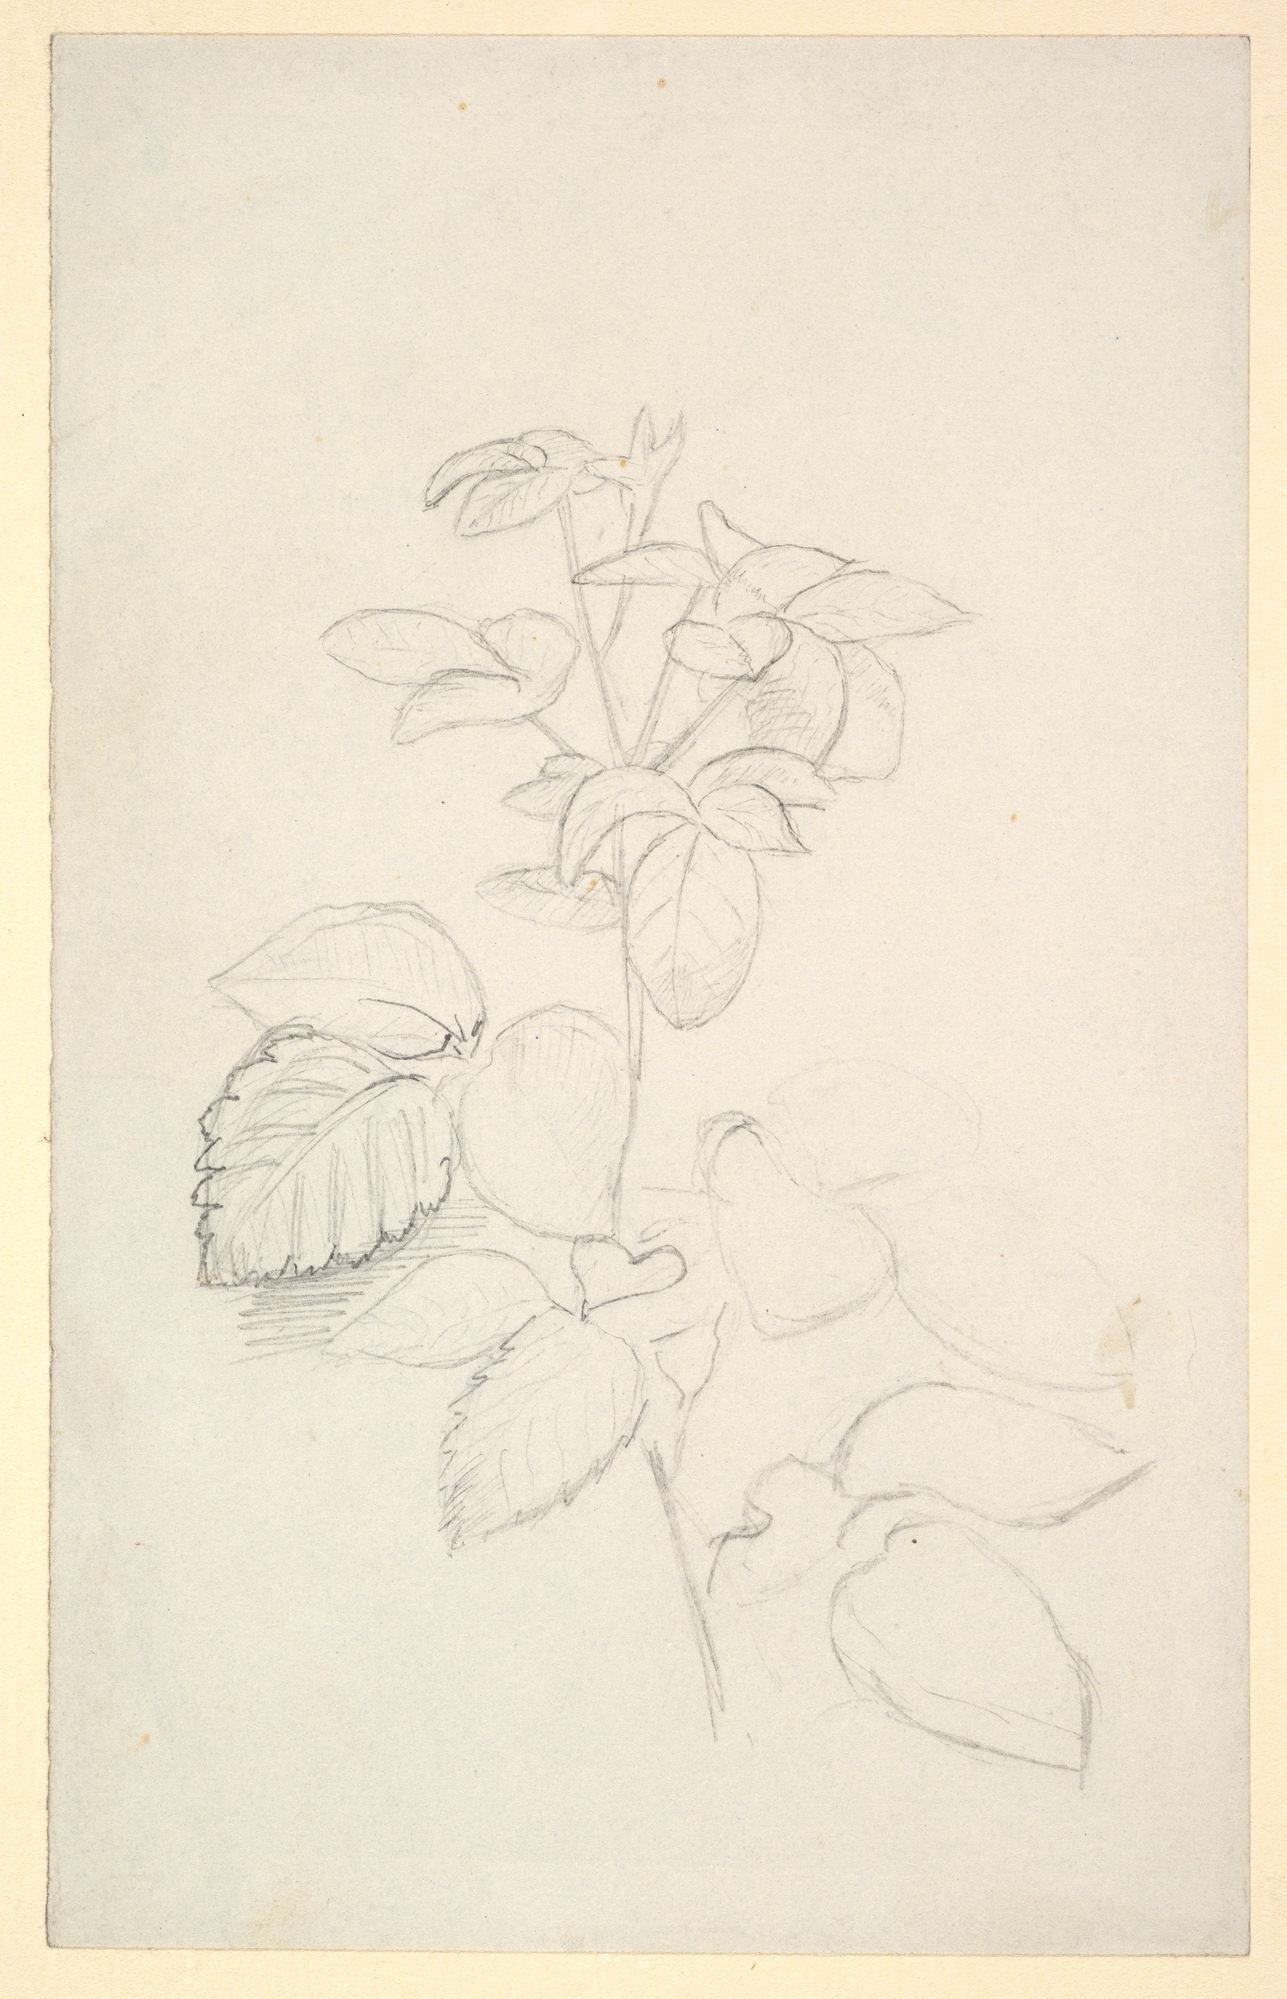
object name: drawing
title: Study of a plant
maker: george richmond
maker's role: artist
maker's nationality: british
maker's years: 1809-1896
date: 1840-1880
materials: chalk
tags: plants,leaves